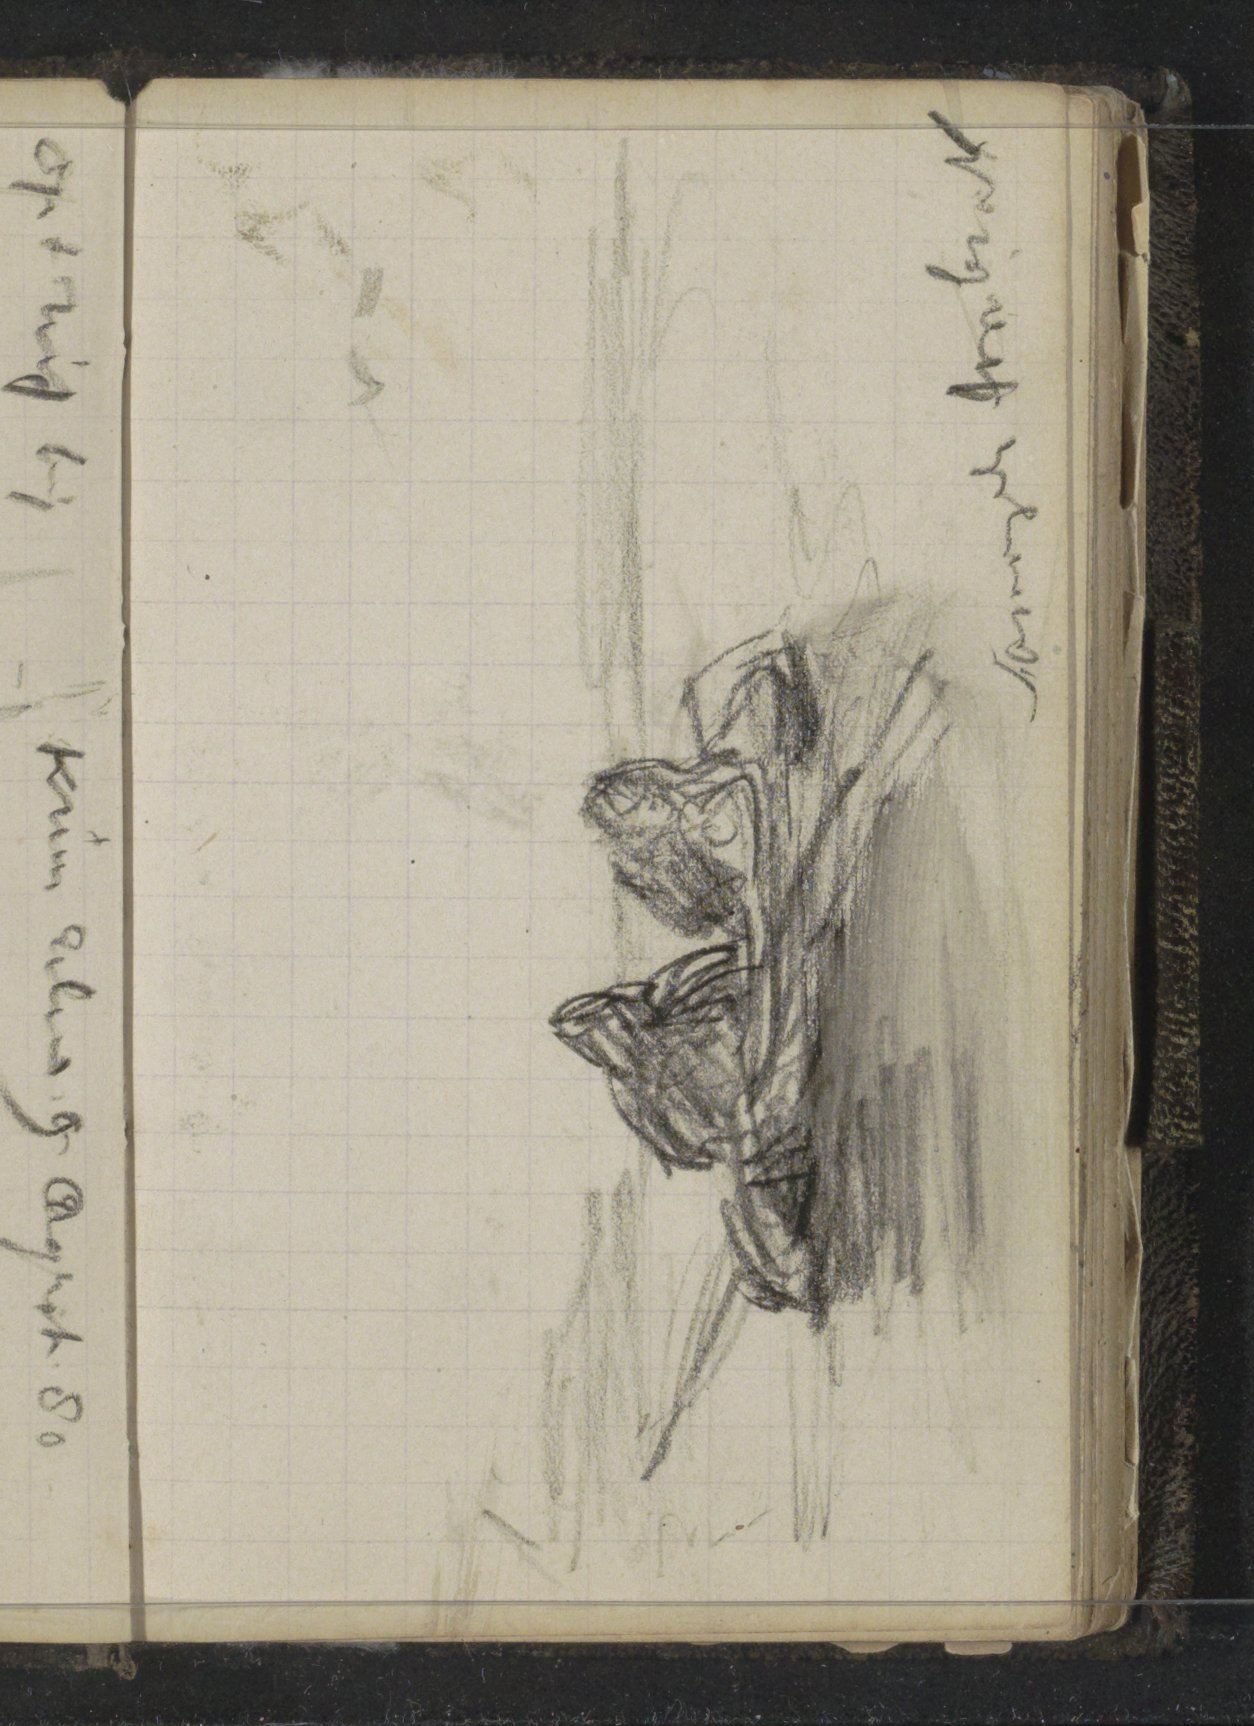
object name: sketchbook leaf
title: Twee Samojeden in een roeiboot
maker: louis apol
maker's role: draughtsman, painter, print maker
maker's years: 1850-1936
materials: chalk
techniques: brush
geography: novaya zemlya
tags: rowing-boat, canoe, etc., landscapes in polar regions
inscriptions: annotation: ‘Samojeden ten brak [?]’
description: Blad 58 recto uit een schetsboek met 110 bladen betekend tijdens de expeditie naar Nova Zembla in 1880.